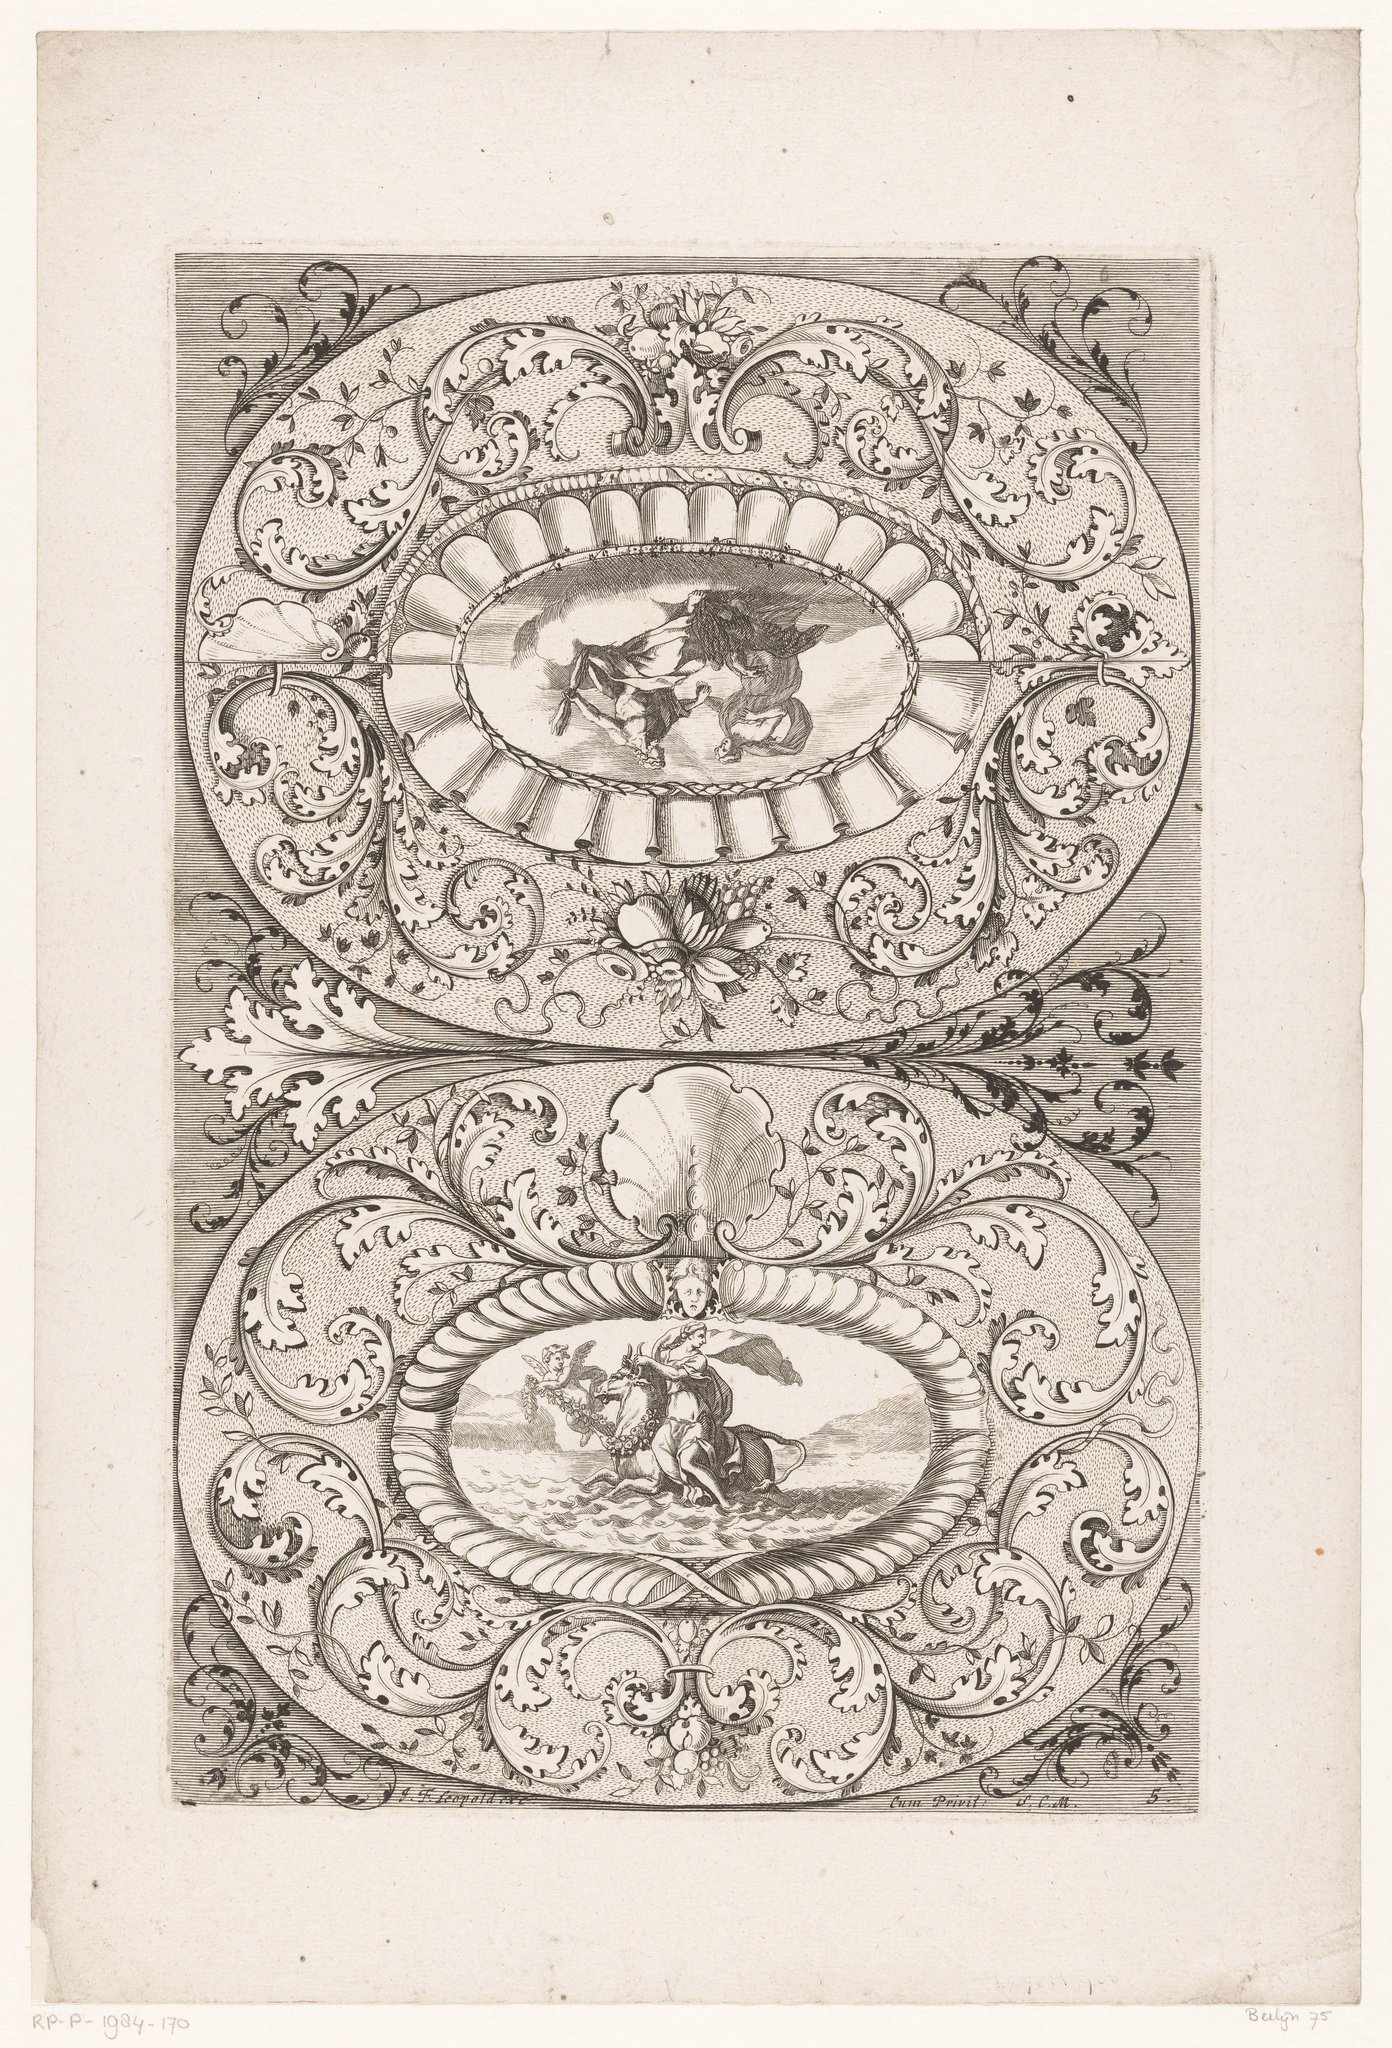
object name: ornament print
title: Medaillons met Europa en Jupiter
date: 1697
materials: paper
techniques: engraving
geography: augsburg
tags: jupiter, usually in the shape of a white bull, abducts europa and carries her across the water, ornament ~ medallion, (story of) jupiter (zeus)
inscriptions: collector's mark: Lugt 2228, collector's mark: Lugt 2760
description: Twee ovale medaillons omgeven door acanthusranken, fruit en schelpmotieven. In het bovenste medaillon zit Jupiter met bliksemschichten en een adelaar op wolken, links van hem staat een vrouw. In het onderste medaillon zit Europa op de rug van Jupiter in de vorm van een stier voortgetrokken door een putto.